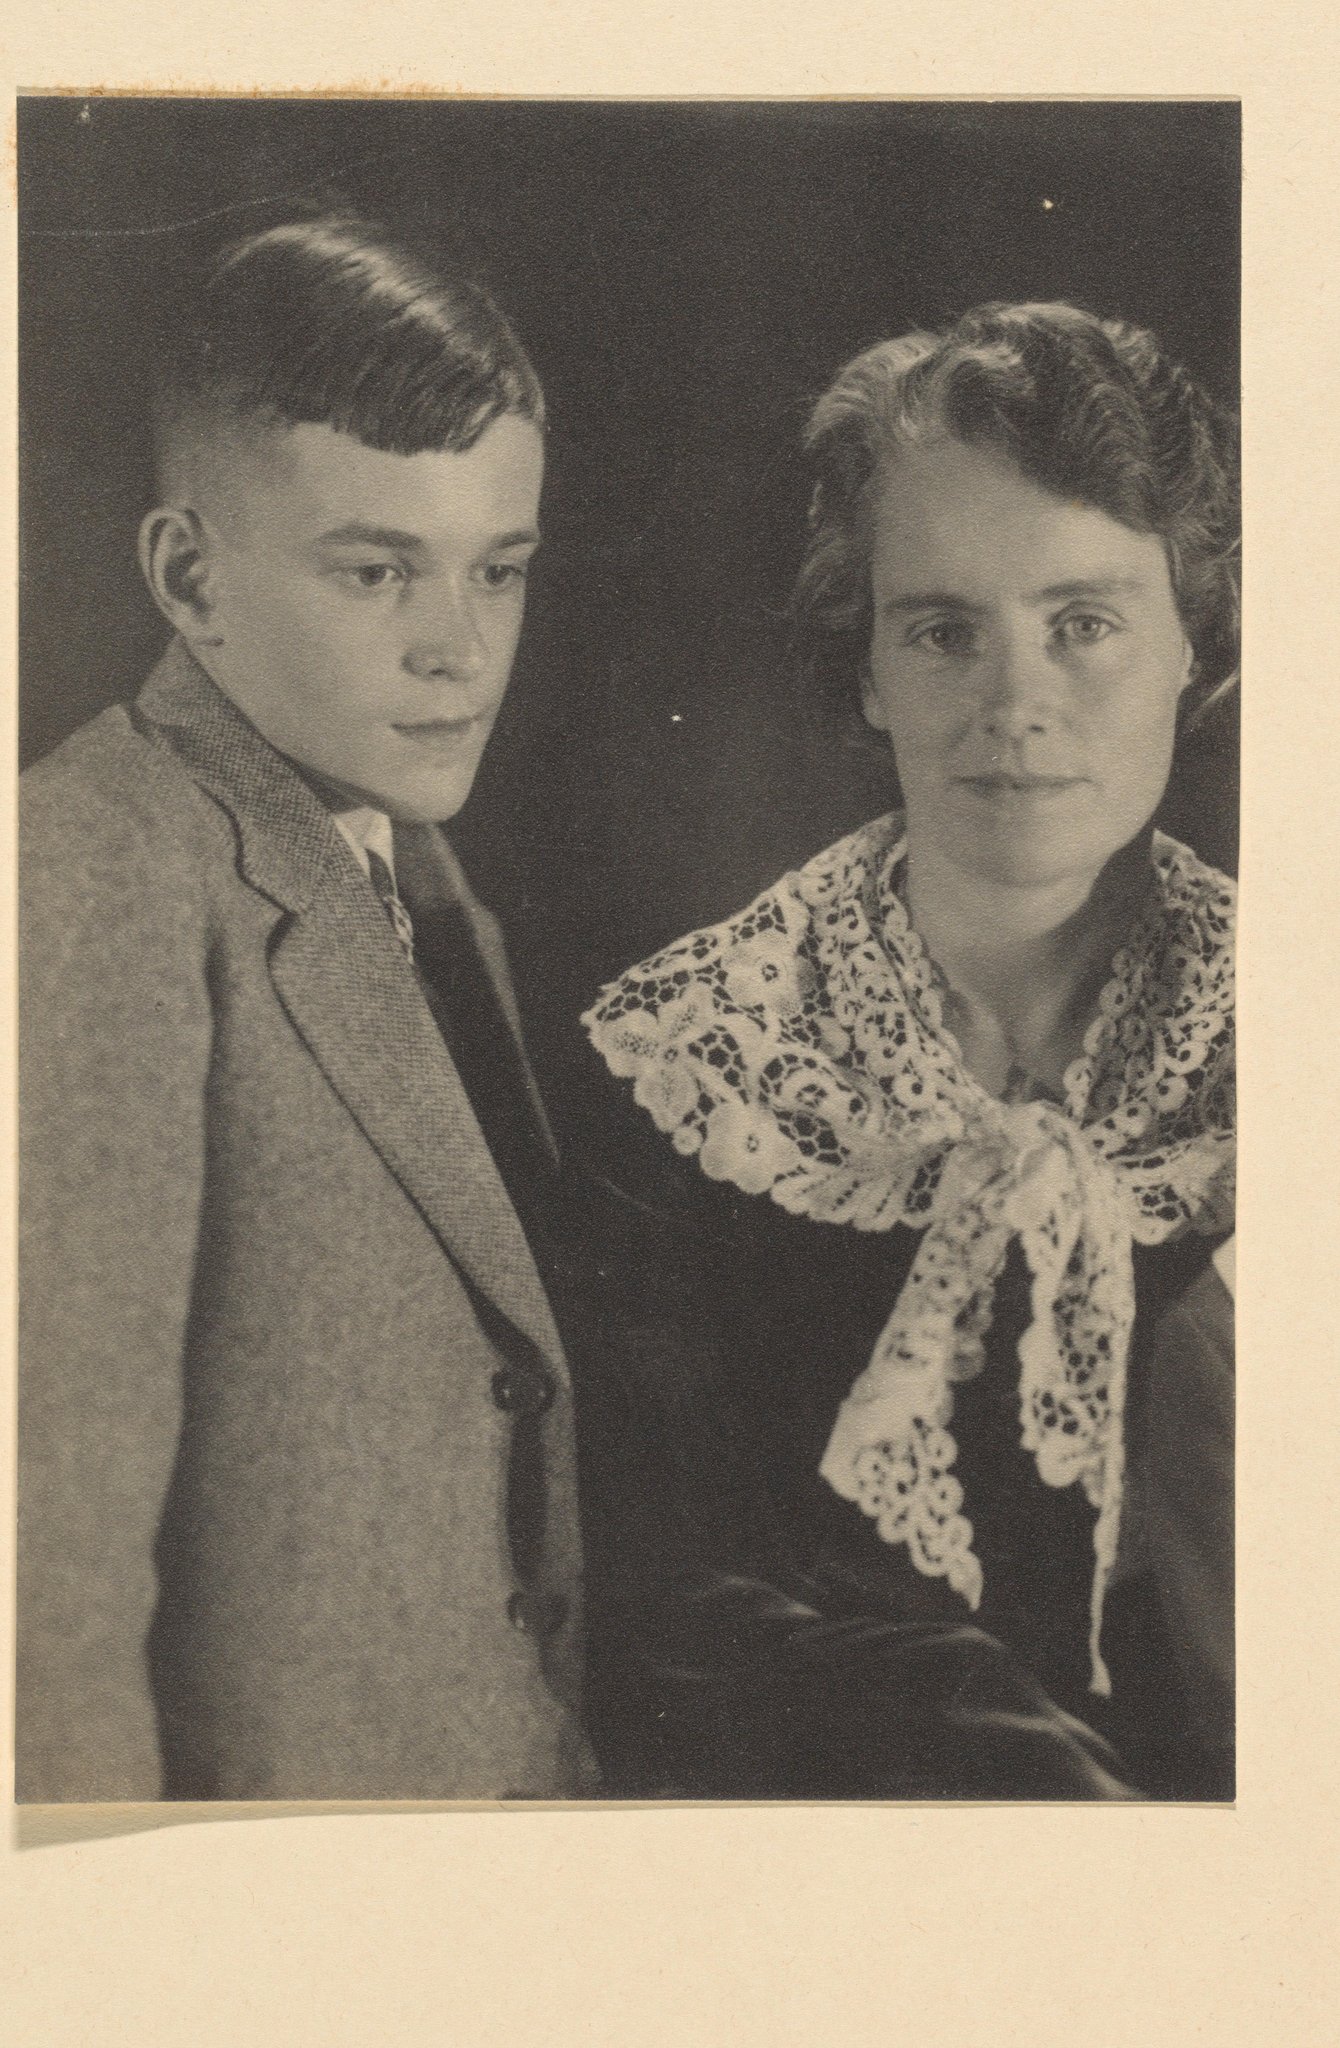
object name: photograph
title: Portret van mevrouw Hondius-Crone en haar zoon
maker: toni arens-tepe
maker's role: fotograaf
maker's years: 1883-1947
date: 1901-1935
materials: cardboard, photographic support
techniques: bromoil process, gelatin silver print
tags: amsterdam, voorschoten, ada helena hondius-crone, mother and child(ren), woman and child(ren) (family group)